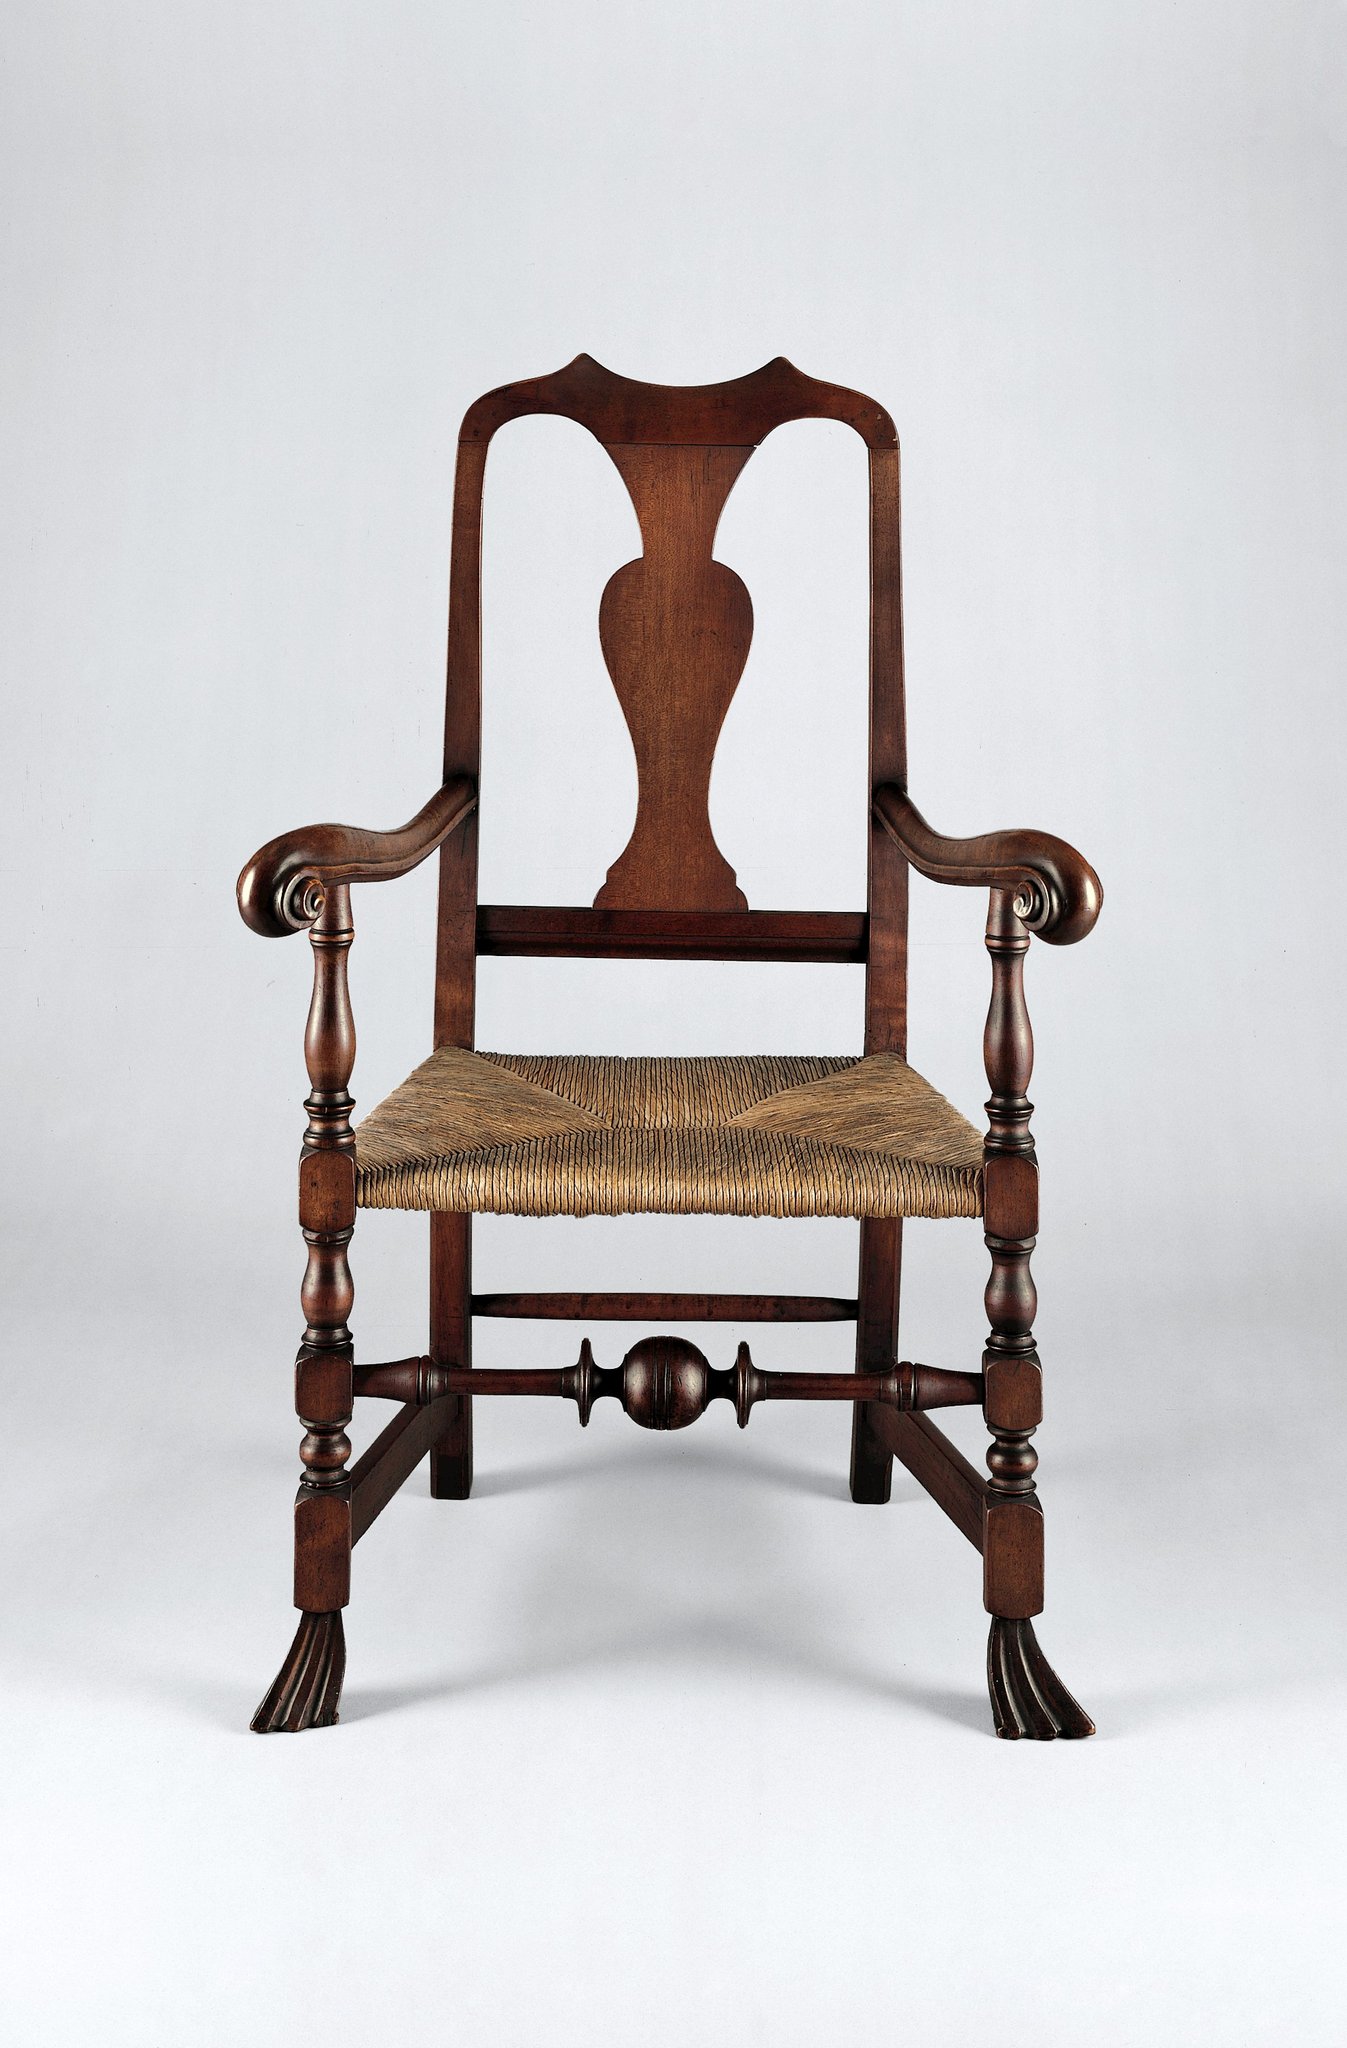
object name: armchair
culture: american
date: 1735-1760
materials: wood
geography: united states